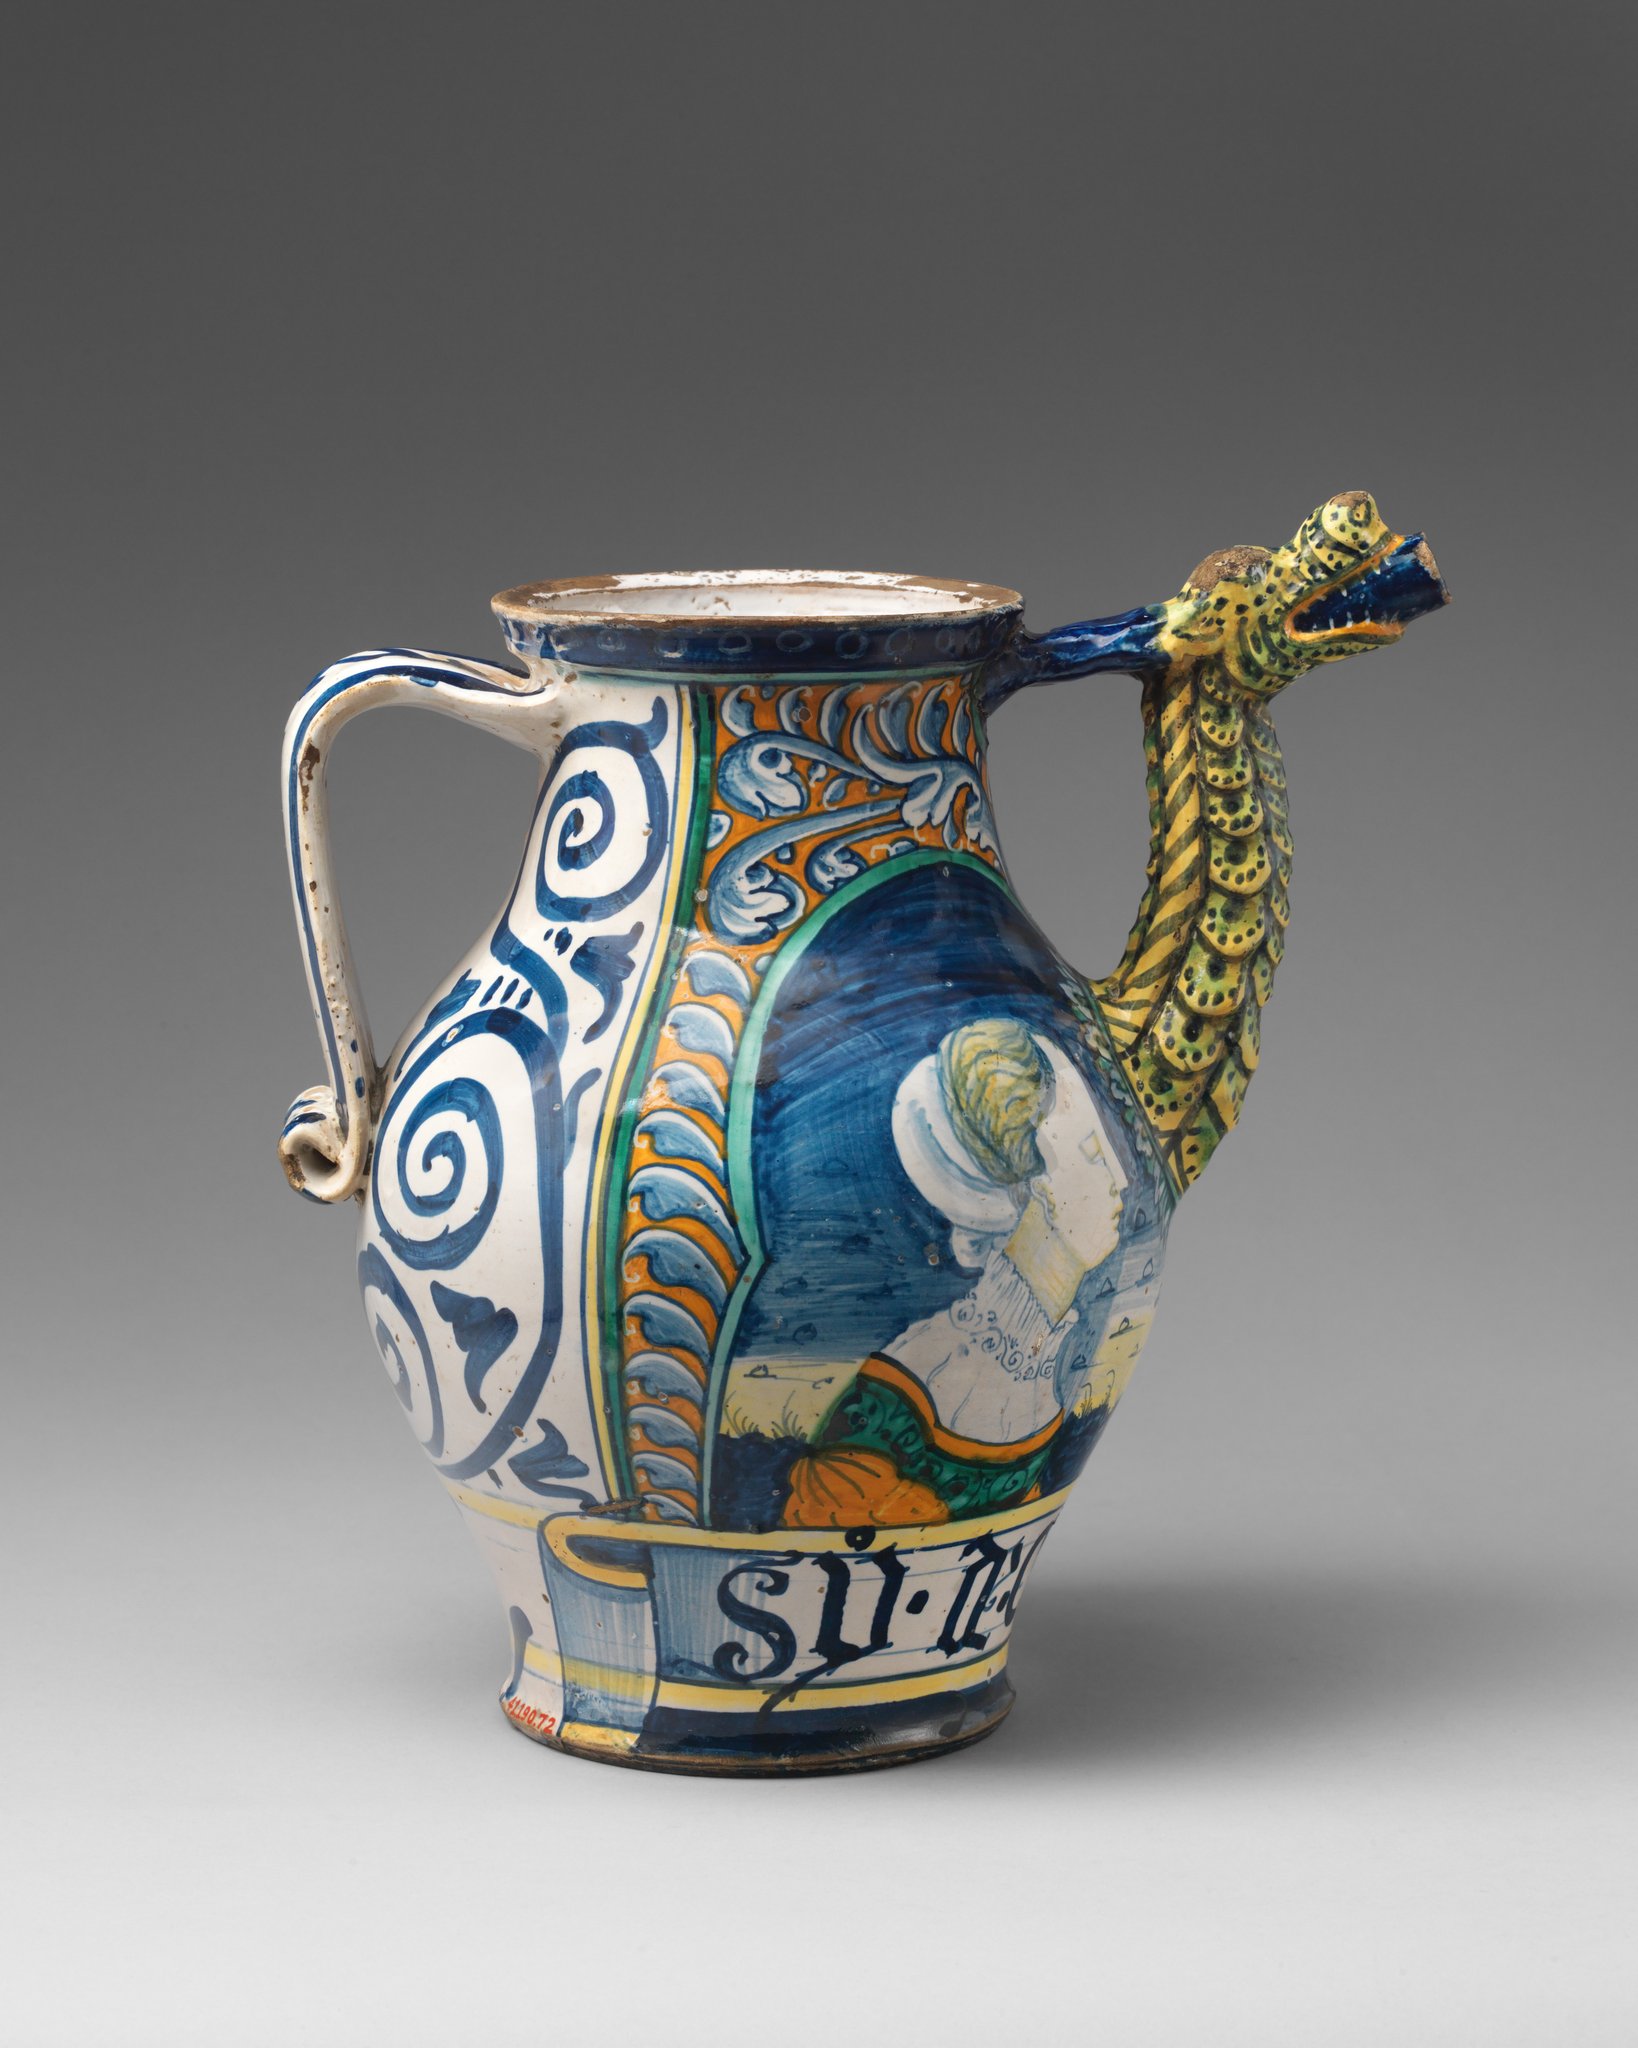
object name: drug pot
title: Drug pot (one of a pair)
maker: orazio pompei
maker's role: maker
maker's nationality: italian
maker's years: 1511-1596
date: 1530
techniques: maiolica, glazing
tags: men,women,dragons